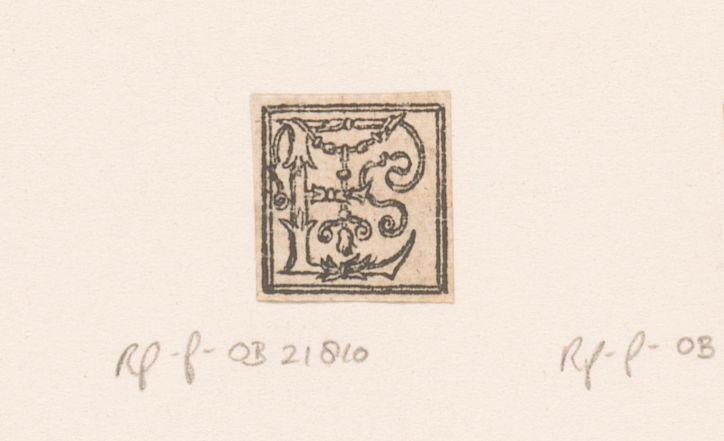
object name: print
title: Letter E: ornament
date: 1556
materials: paper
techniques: letterpress printing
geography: zurich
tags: initial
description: Prent afkomstig uit: Bibel, die gantze, das ist alle Bücher alts und news Testaments (...). Zürich: Johann Froschauer, 1556.